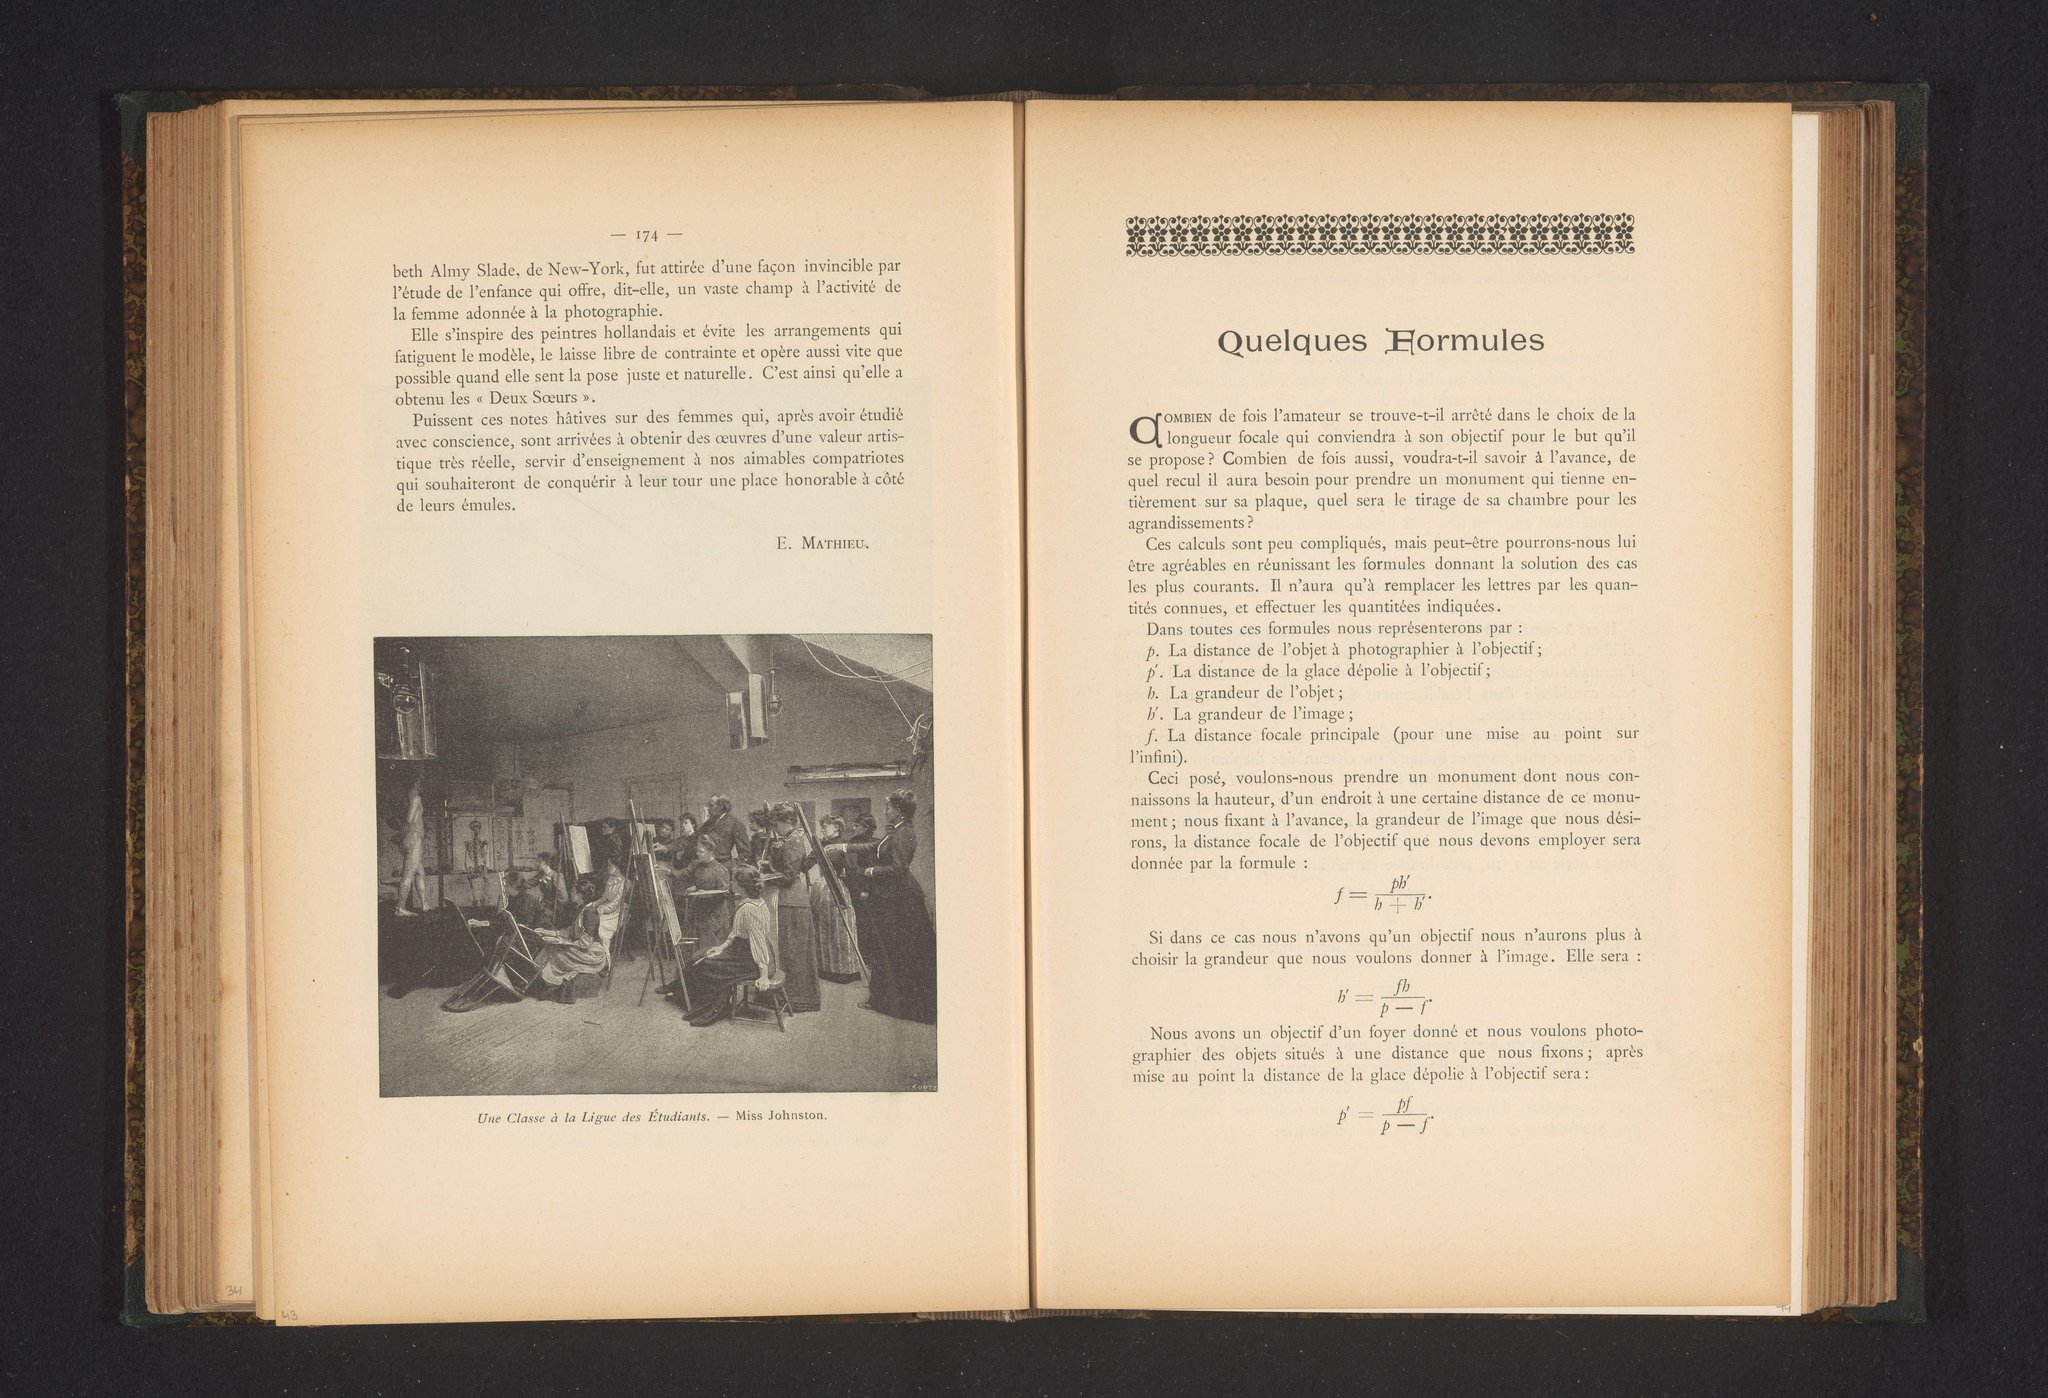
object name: page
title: Les in modeltekenen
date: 1890-1895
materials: paper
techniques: autotype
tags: drawing-lesson